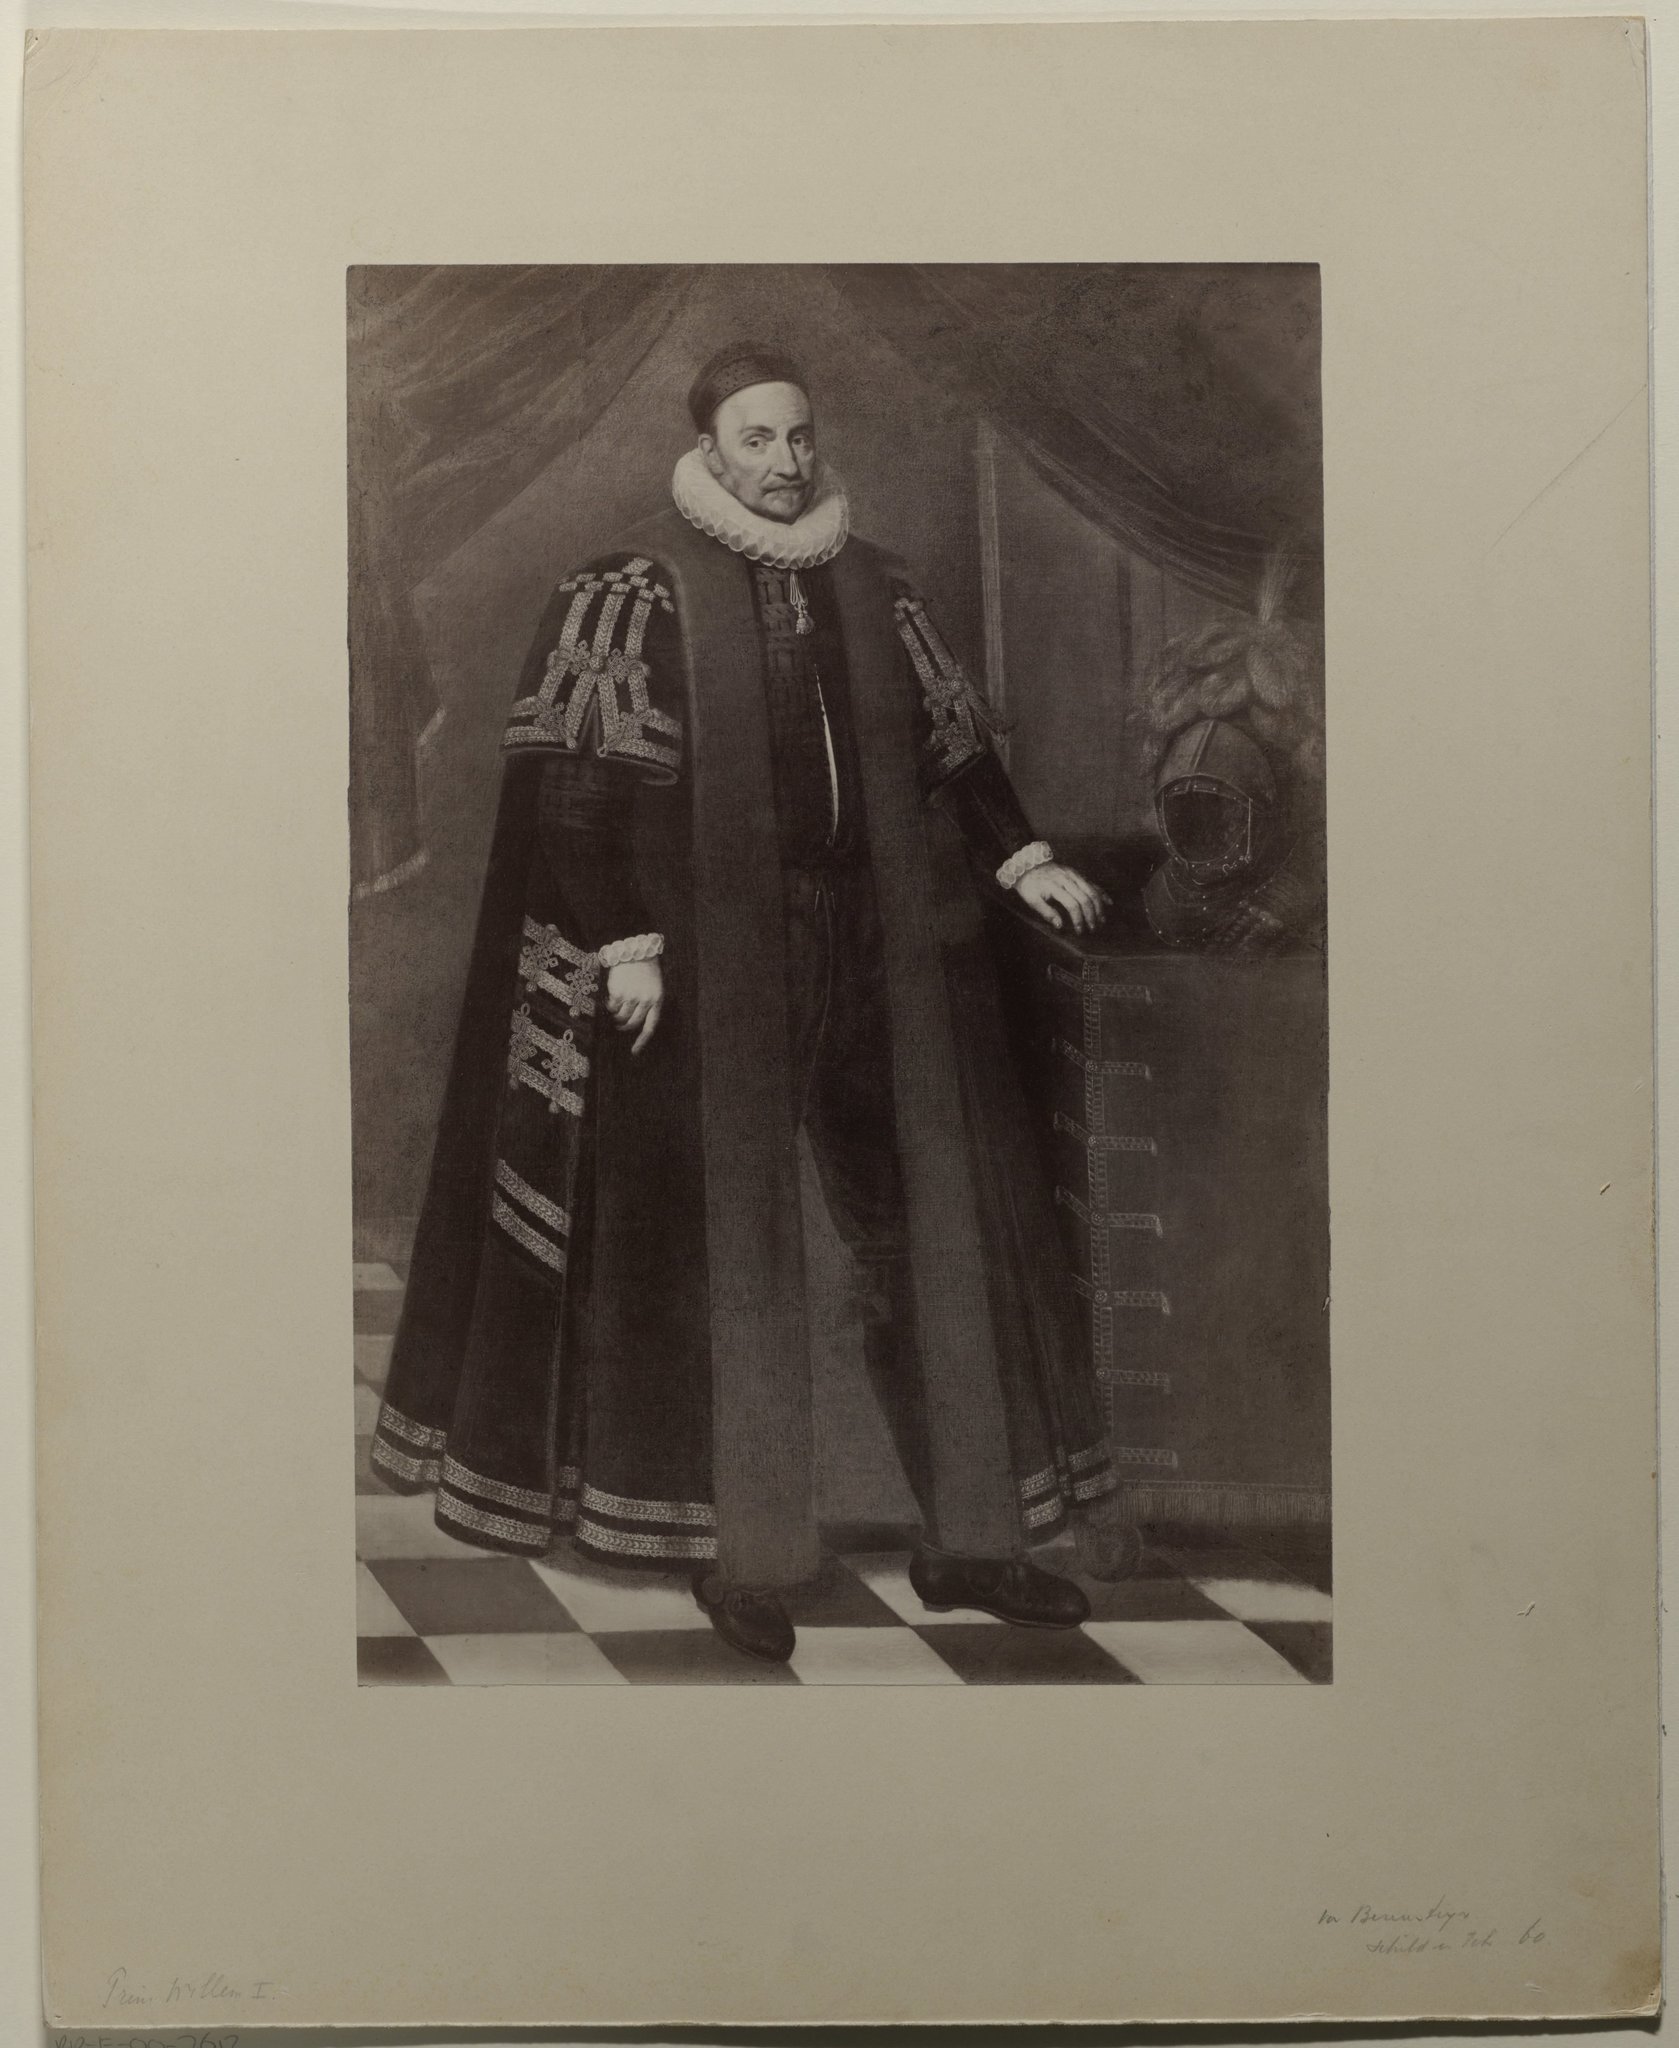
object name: photograph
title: Portret van Willem I, prins van Oranje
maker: Anonymous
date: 1850-1930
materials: photographic support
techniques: photography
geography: netherlands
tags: delft, william i (prince of orange)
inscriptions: collector's mark: Lugt 2233, collector's mark: Lugt 2228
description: De hier vermelde titel verwijst naar de hoogst verkregen titel van de geportretteerde, niet per se naar de titel die de geportretteerde op deze voorstelling draagt.